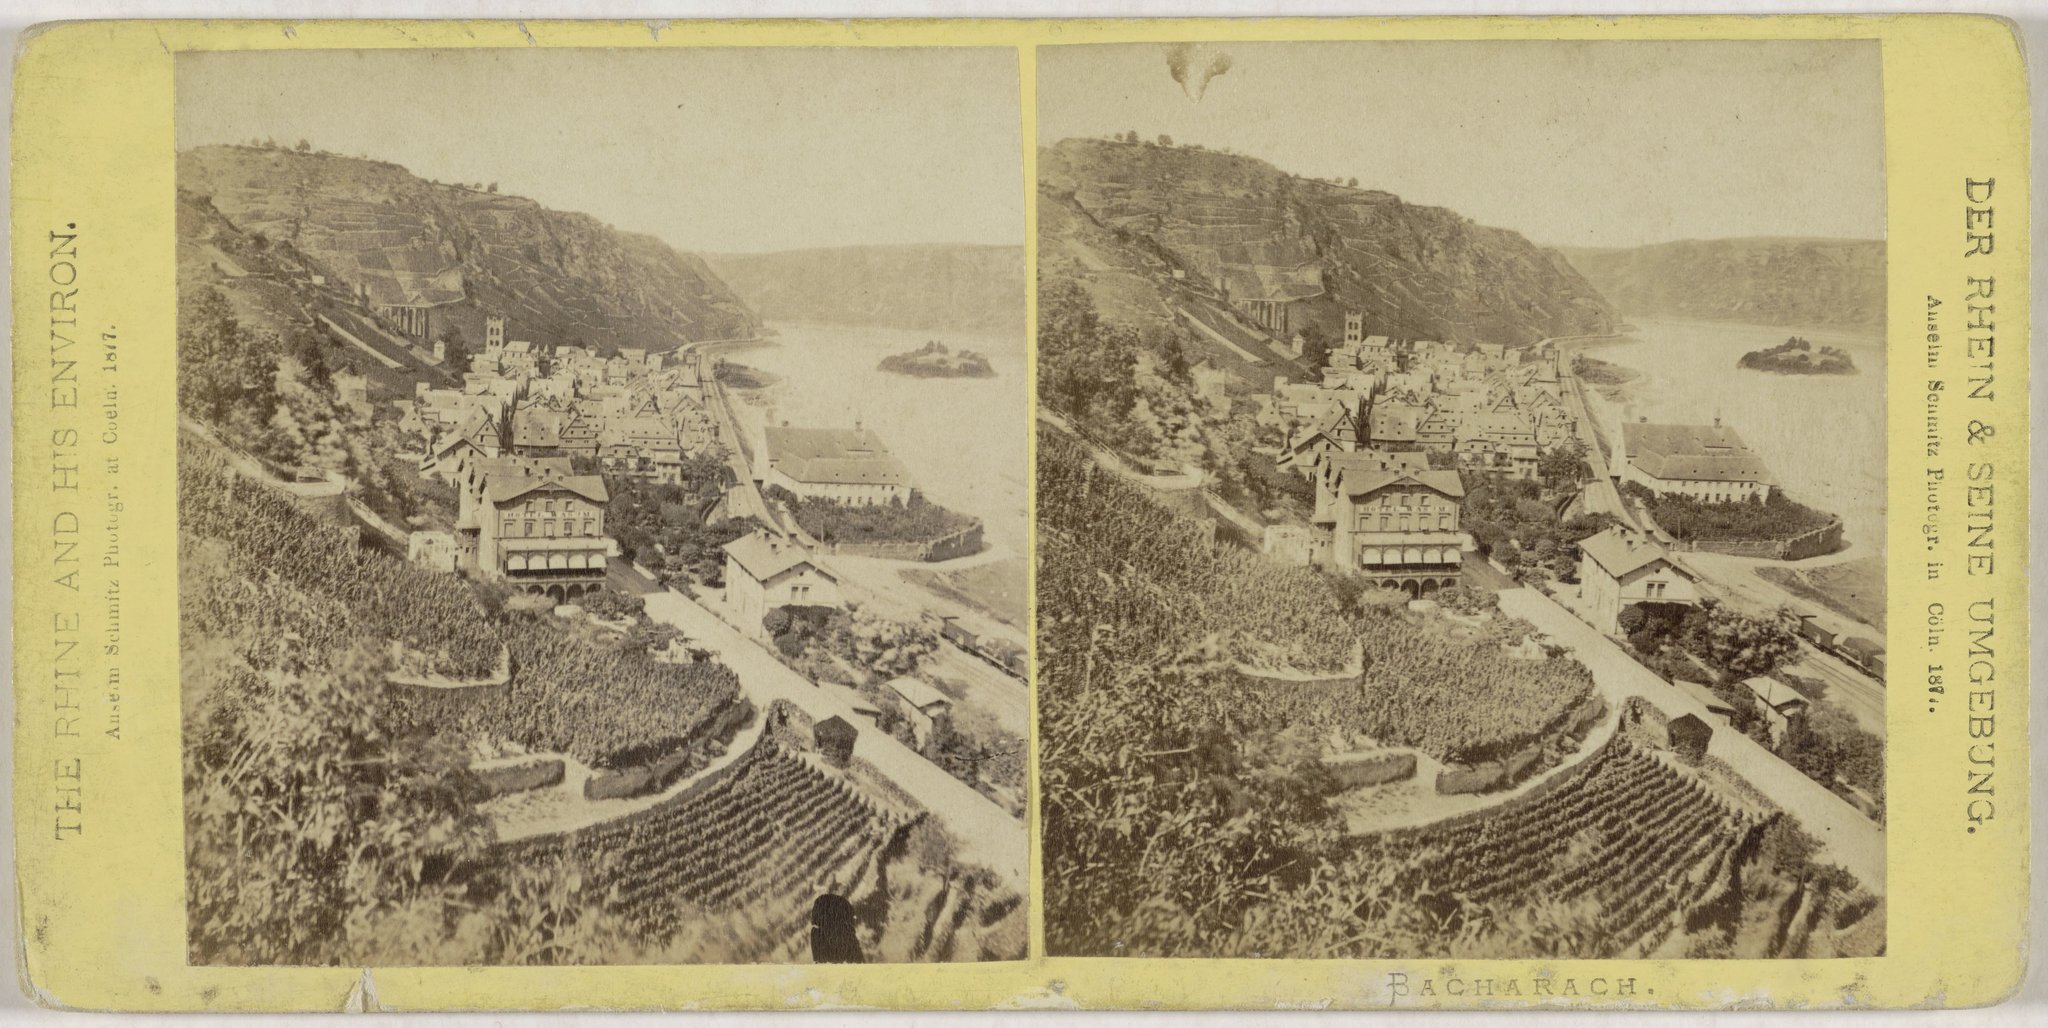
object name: stereograph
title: Bacharach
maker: anselm schmitz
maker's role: publisher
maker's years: 1831-1903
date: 1877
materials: cardboard, paper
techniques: albumen print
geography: bacharach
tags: dale, valley, village